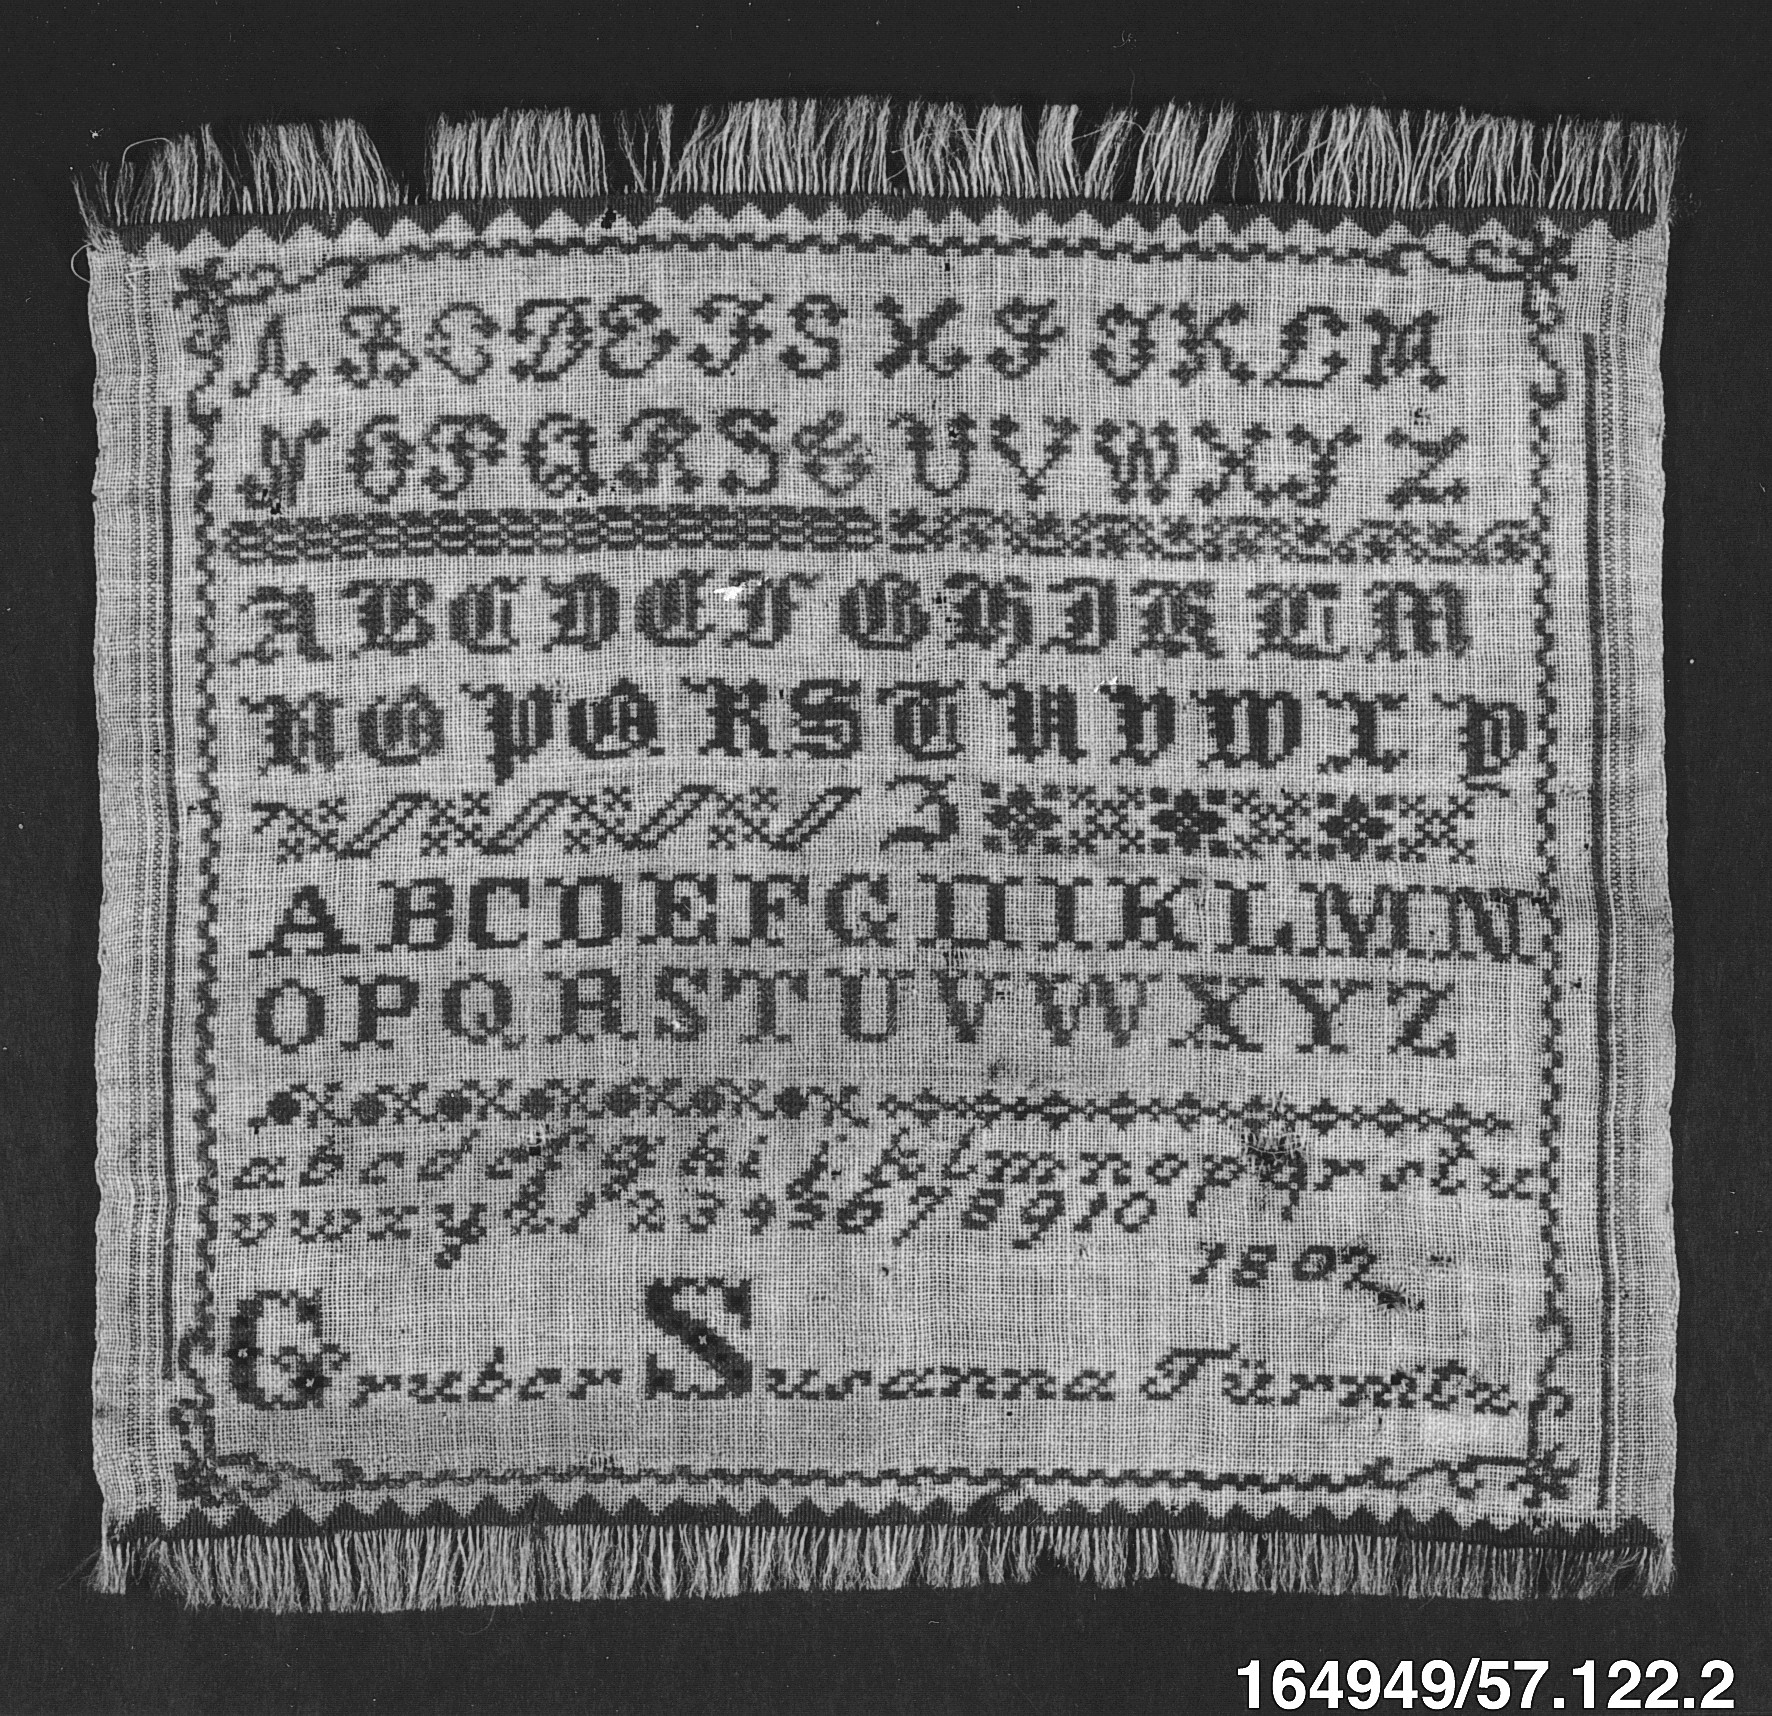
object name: sampler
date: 1802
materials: canvas, cotton, wool